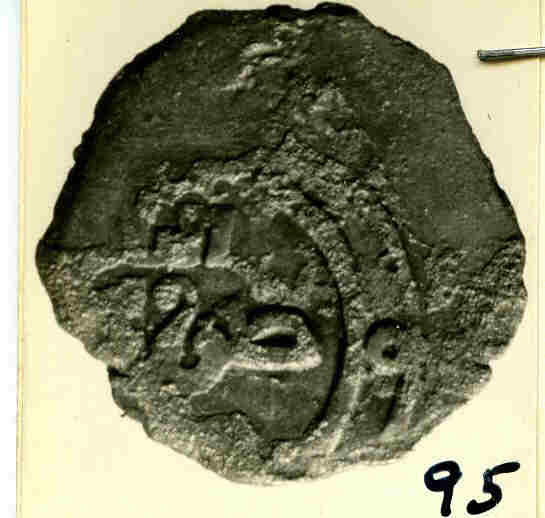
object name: coin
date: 1167-1233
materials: copper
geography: iran